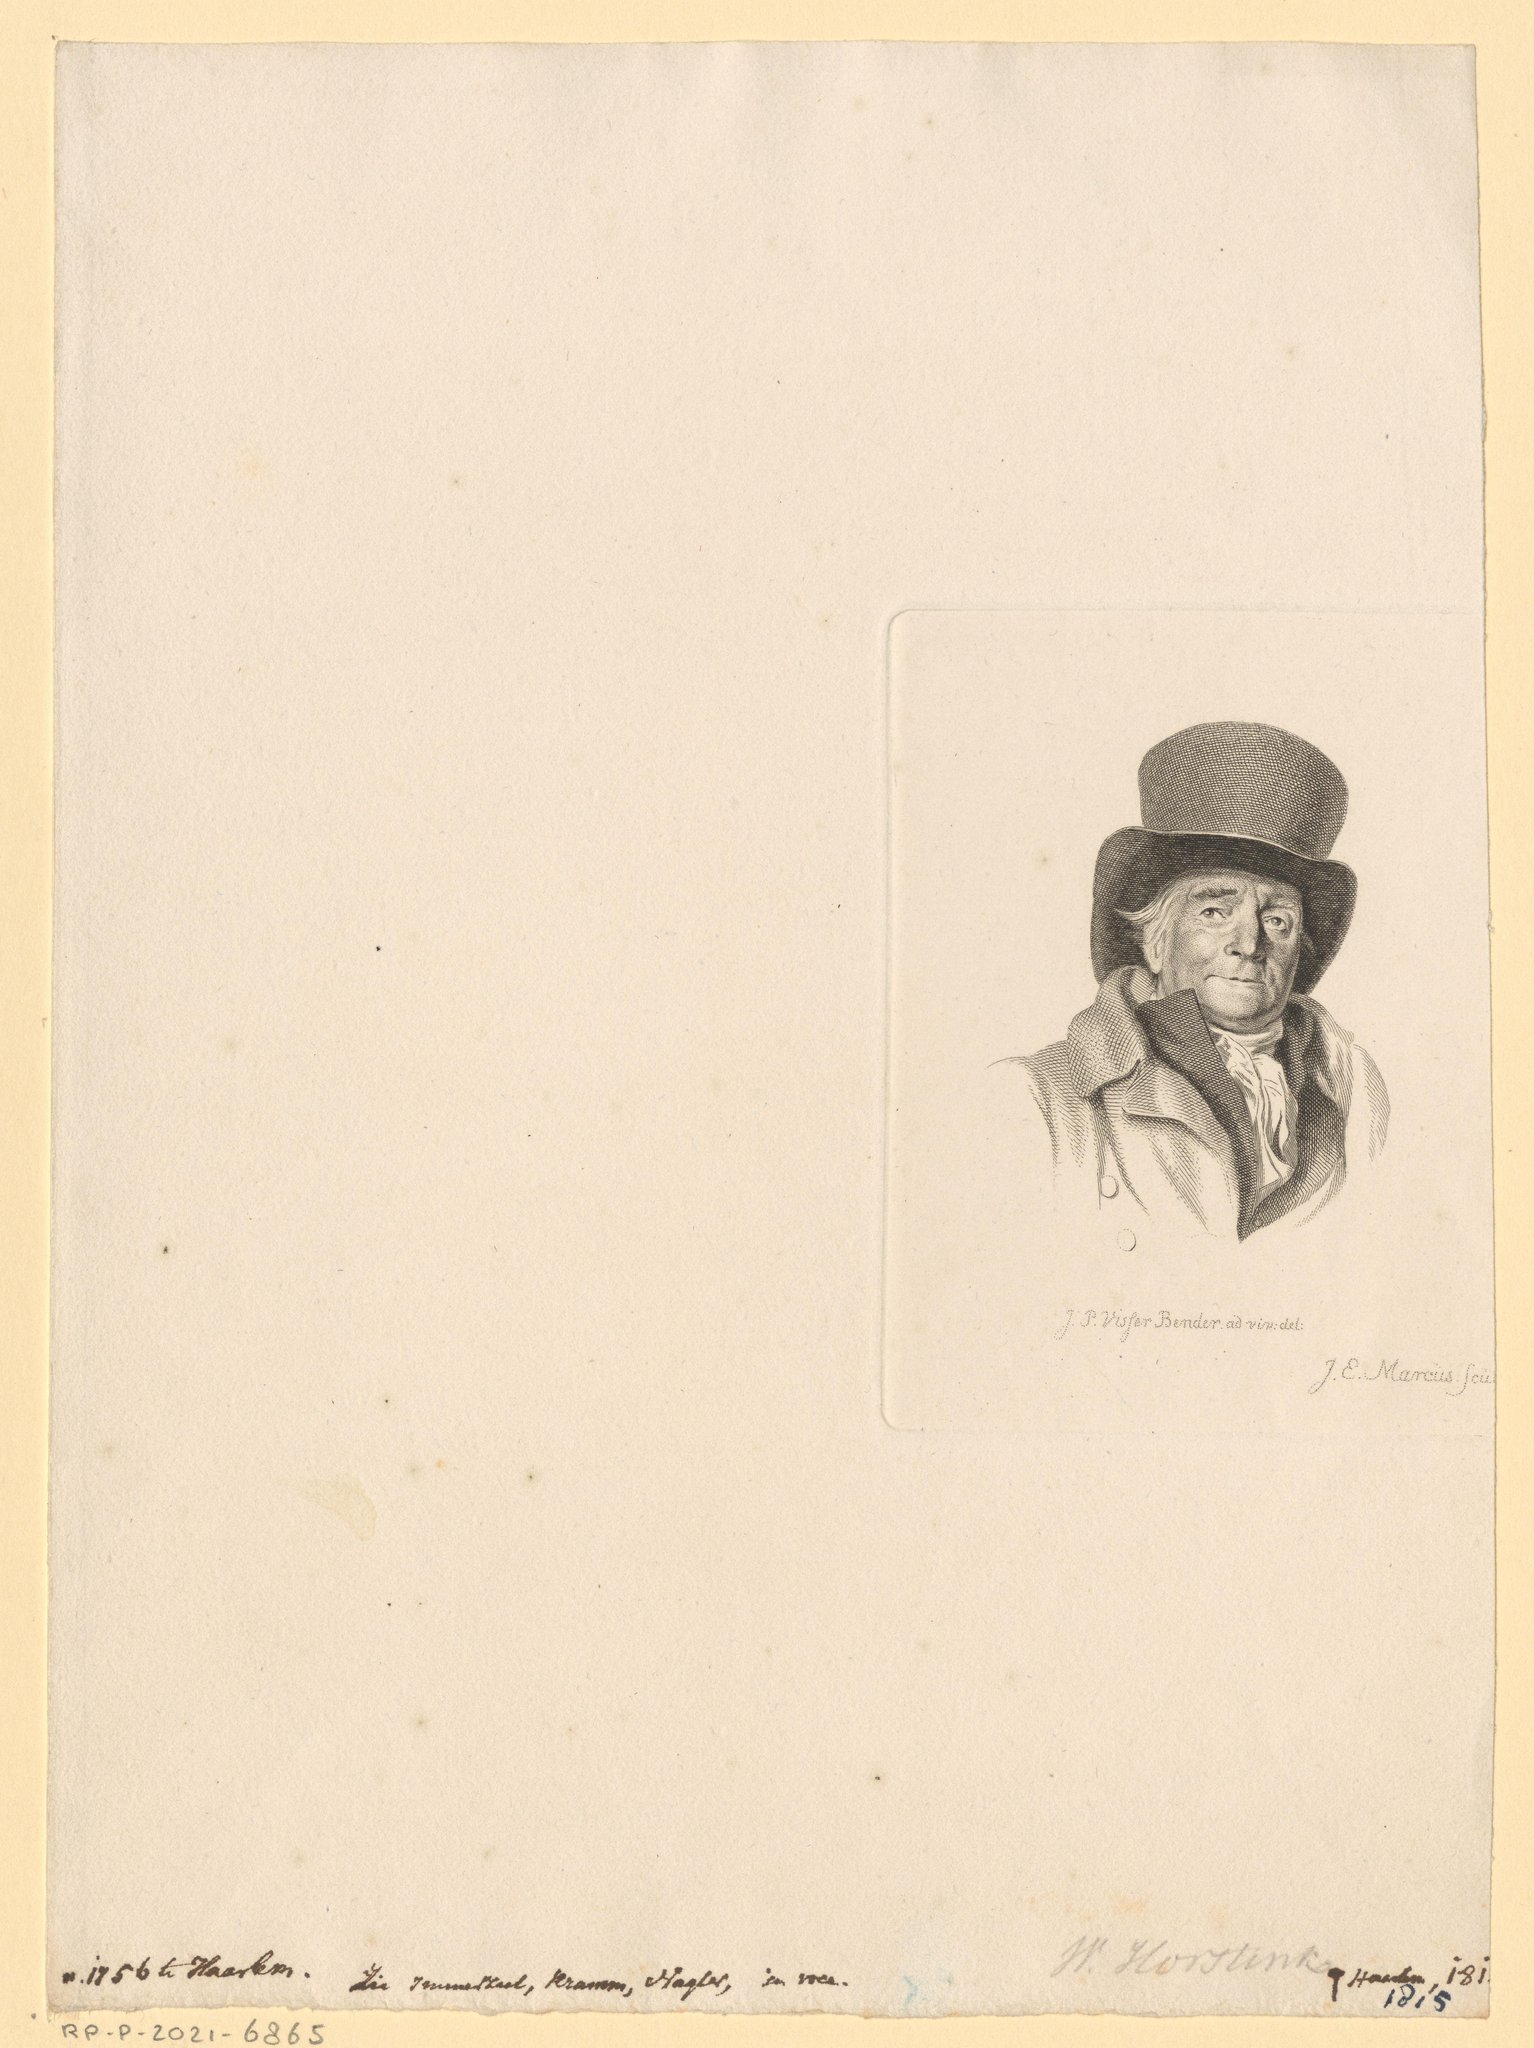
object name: print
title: Portret van Johannes Petrus van Horstok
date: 1813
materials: paper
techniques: etching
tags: painter, print maker, draughtsman, johannes petrus van horstok, historical persons, portrait, self-portrait of artist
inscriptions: inscription: ‘n 1756 te Haarlem (...)’